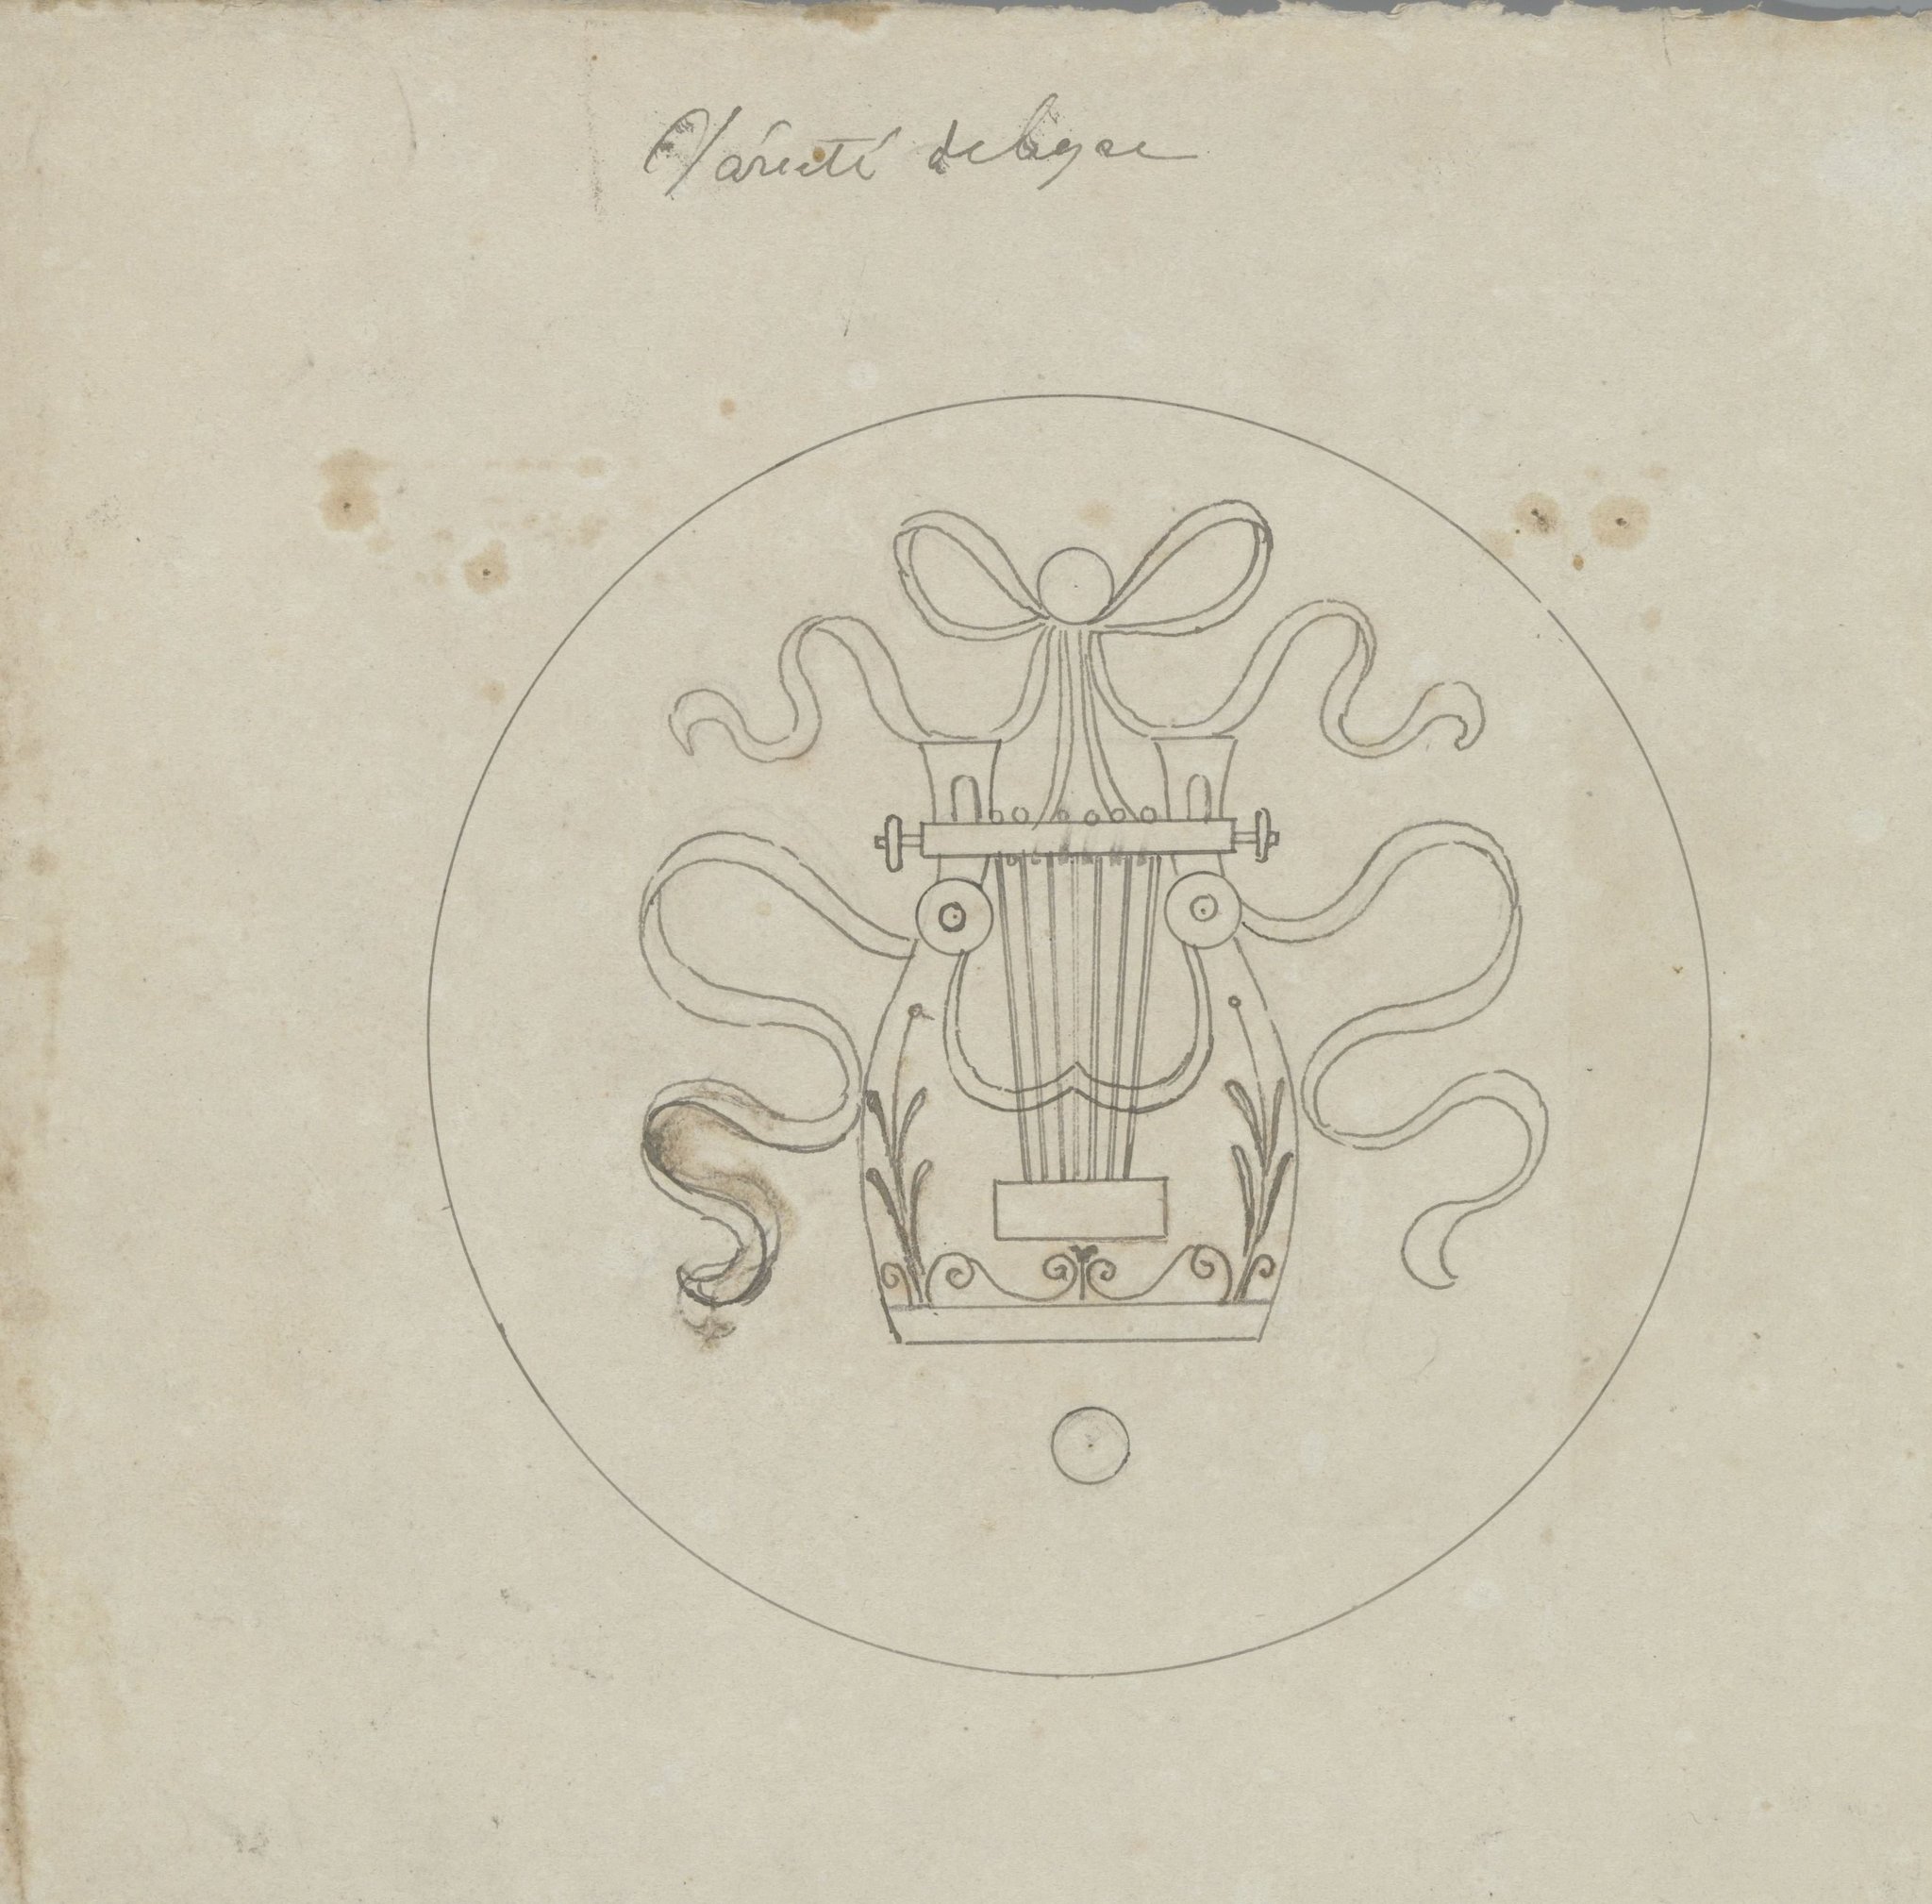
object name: design drawing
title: Ontwerp voor marqueterie van aan linten opgehangen muziekinstrument(en) in rond medaillon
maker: pierre félix van doren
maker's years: 1797-1856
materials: graphite, ink, paper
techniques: pen in black ink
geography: brussels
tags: trophy, i.e.: decorative arrangement of symbolic or typical objects ~ ornament, lyre, cithara, psaltery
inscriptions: inscription: ‘Variété de lyre’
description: Een van 103 ontwerpen voor marqueterie van aan linten opgehangen muziekinstrumenten in ronde medaillons, bestemd voor de set stoelen gemaakt door Van Doren voor de grote zaal van het Paleis van de Prins van Oranje in Brussel in 1828.